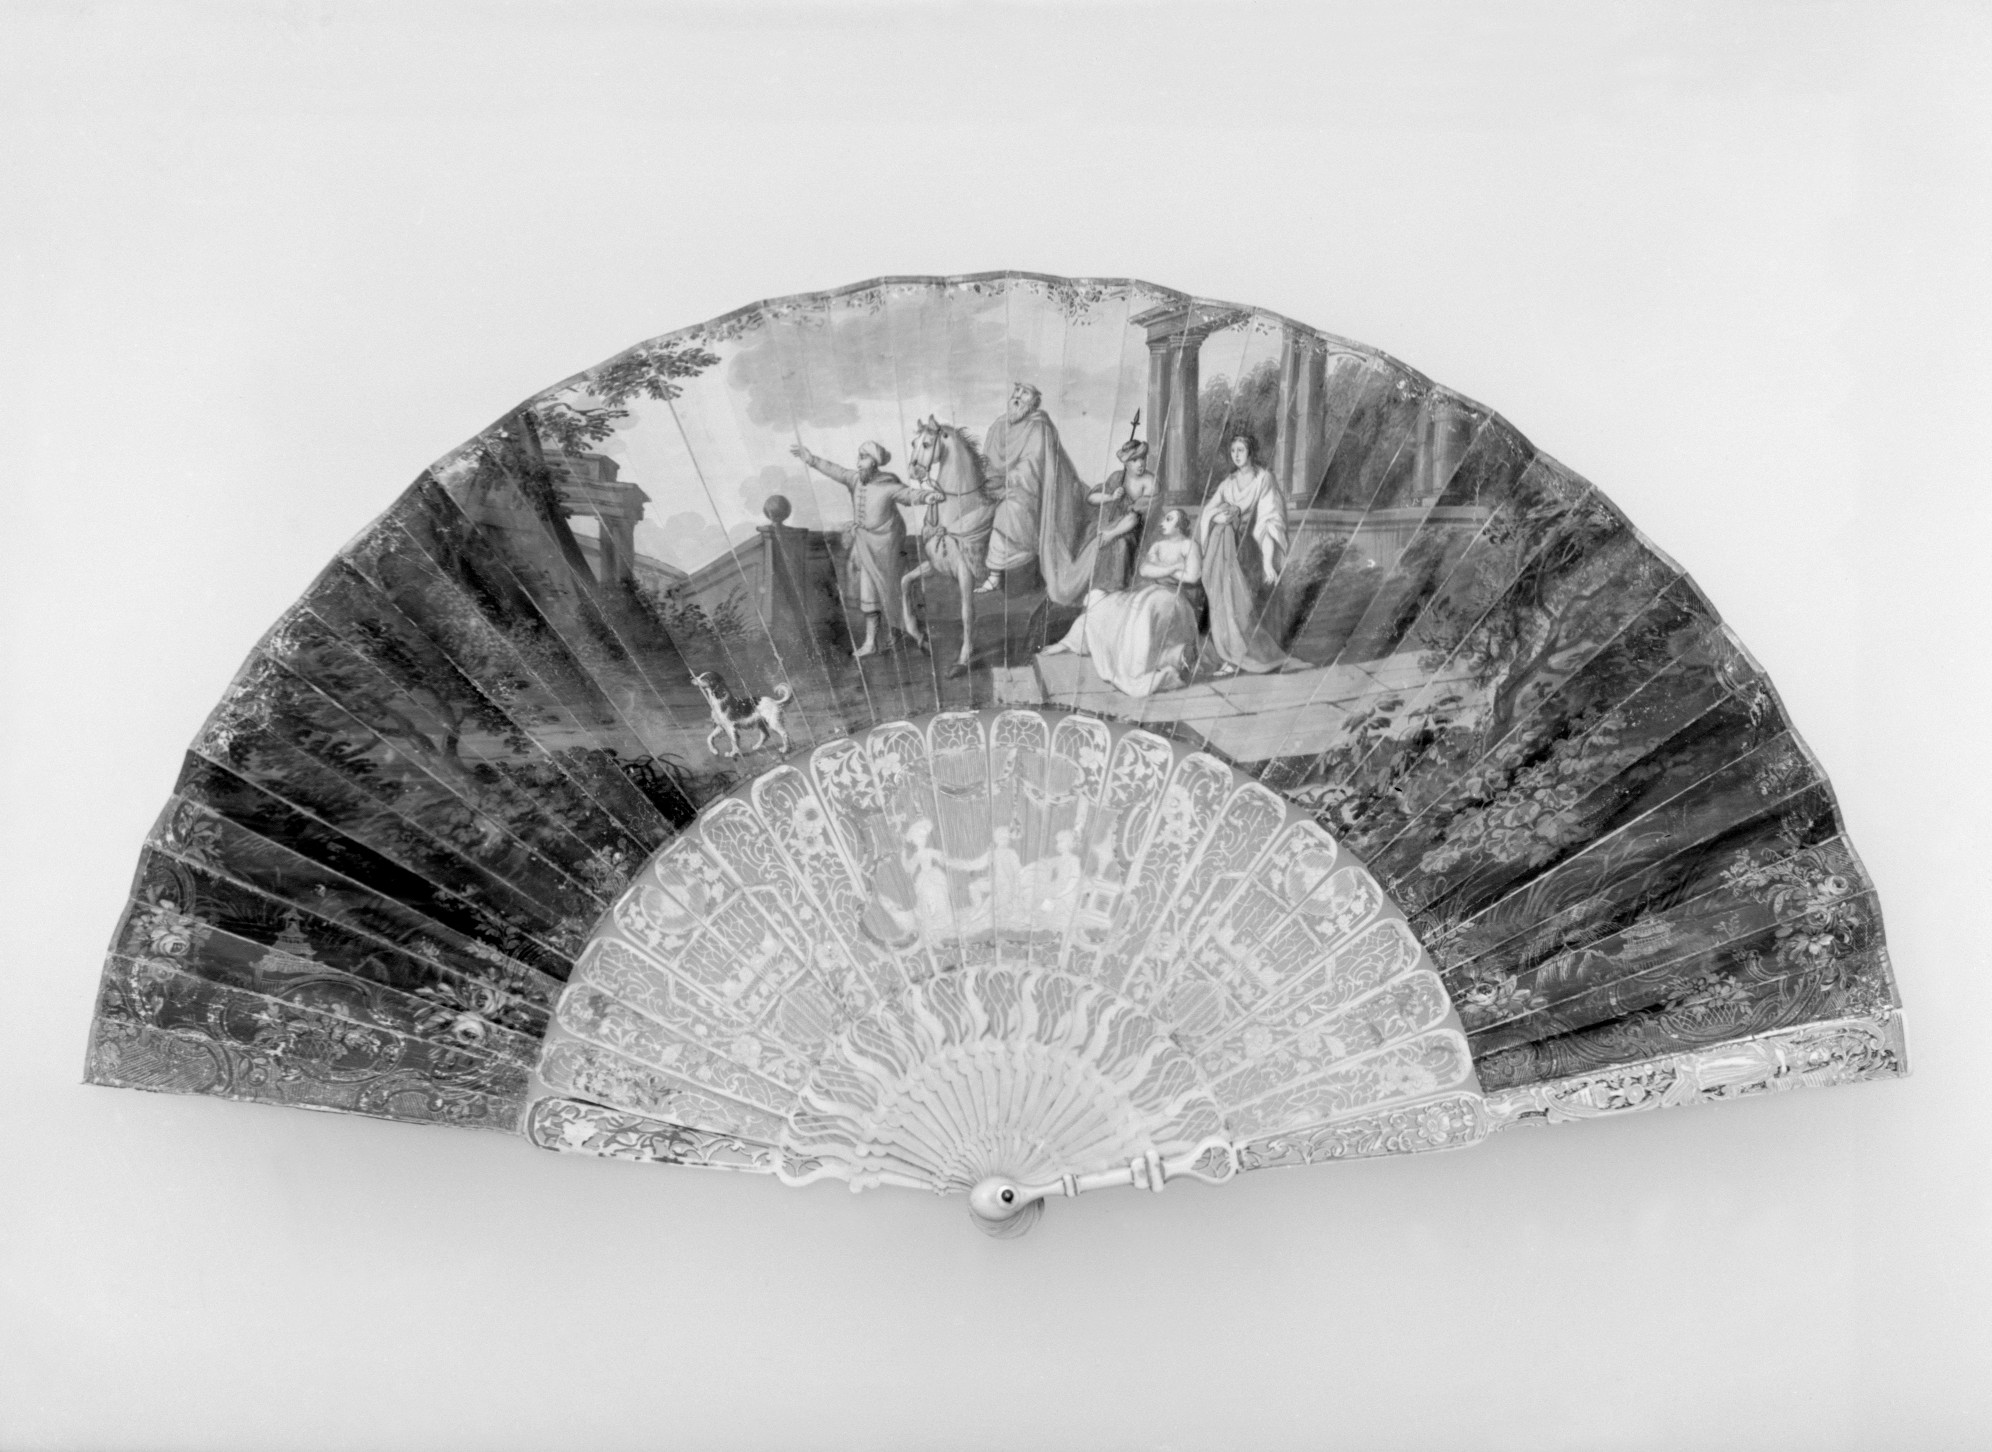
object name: fan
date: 1751-1775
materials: ivory, paper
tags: men,women,dogs,horses,flowers,trees